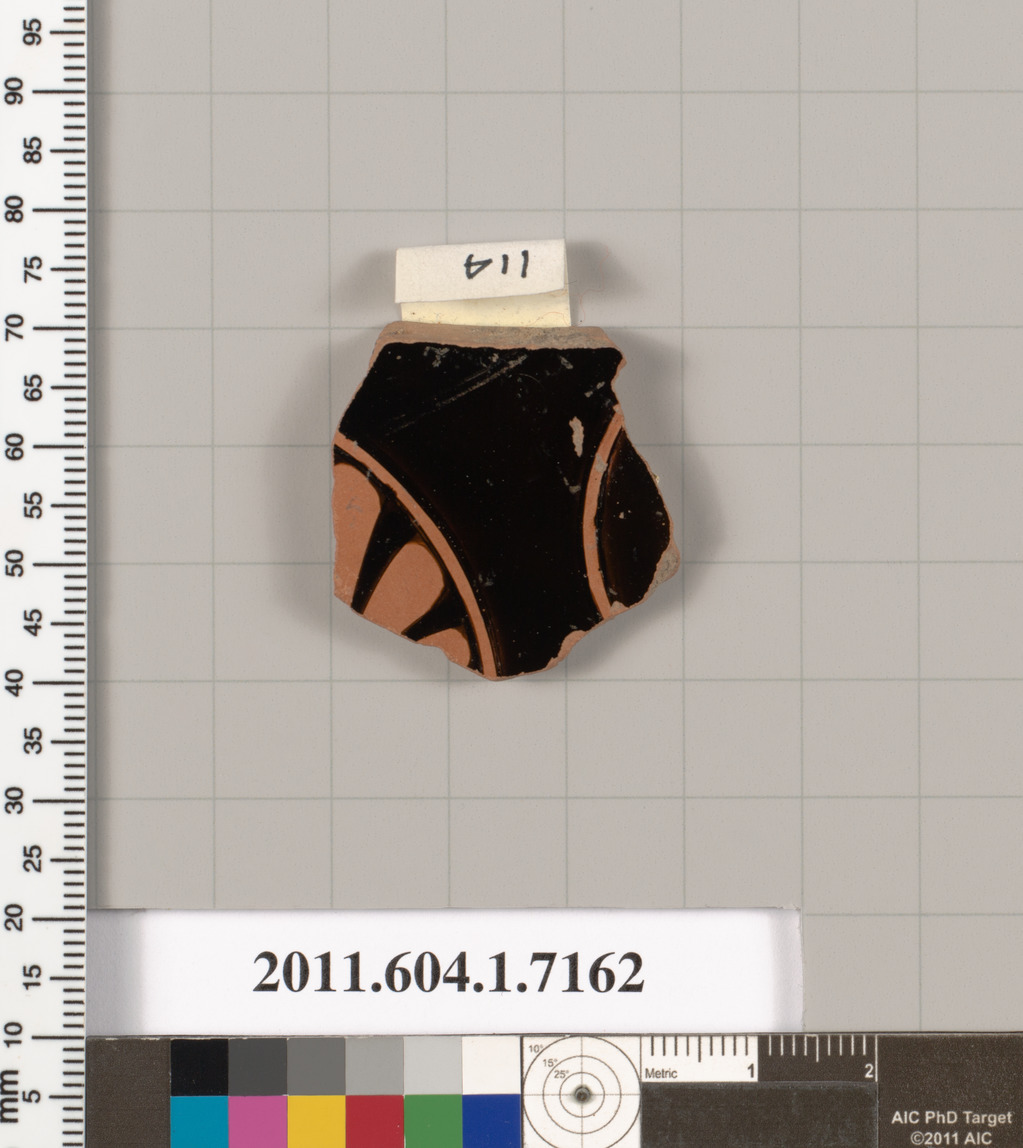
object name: kylix fragment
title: Terracotta fragment of a kylix (drinking cup)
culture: greek, attic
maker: makron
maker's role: artist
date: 500-480 BCE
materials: terracotta